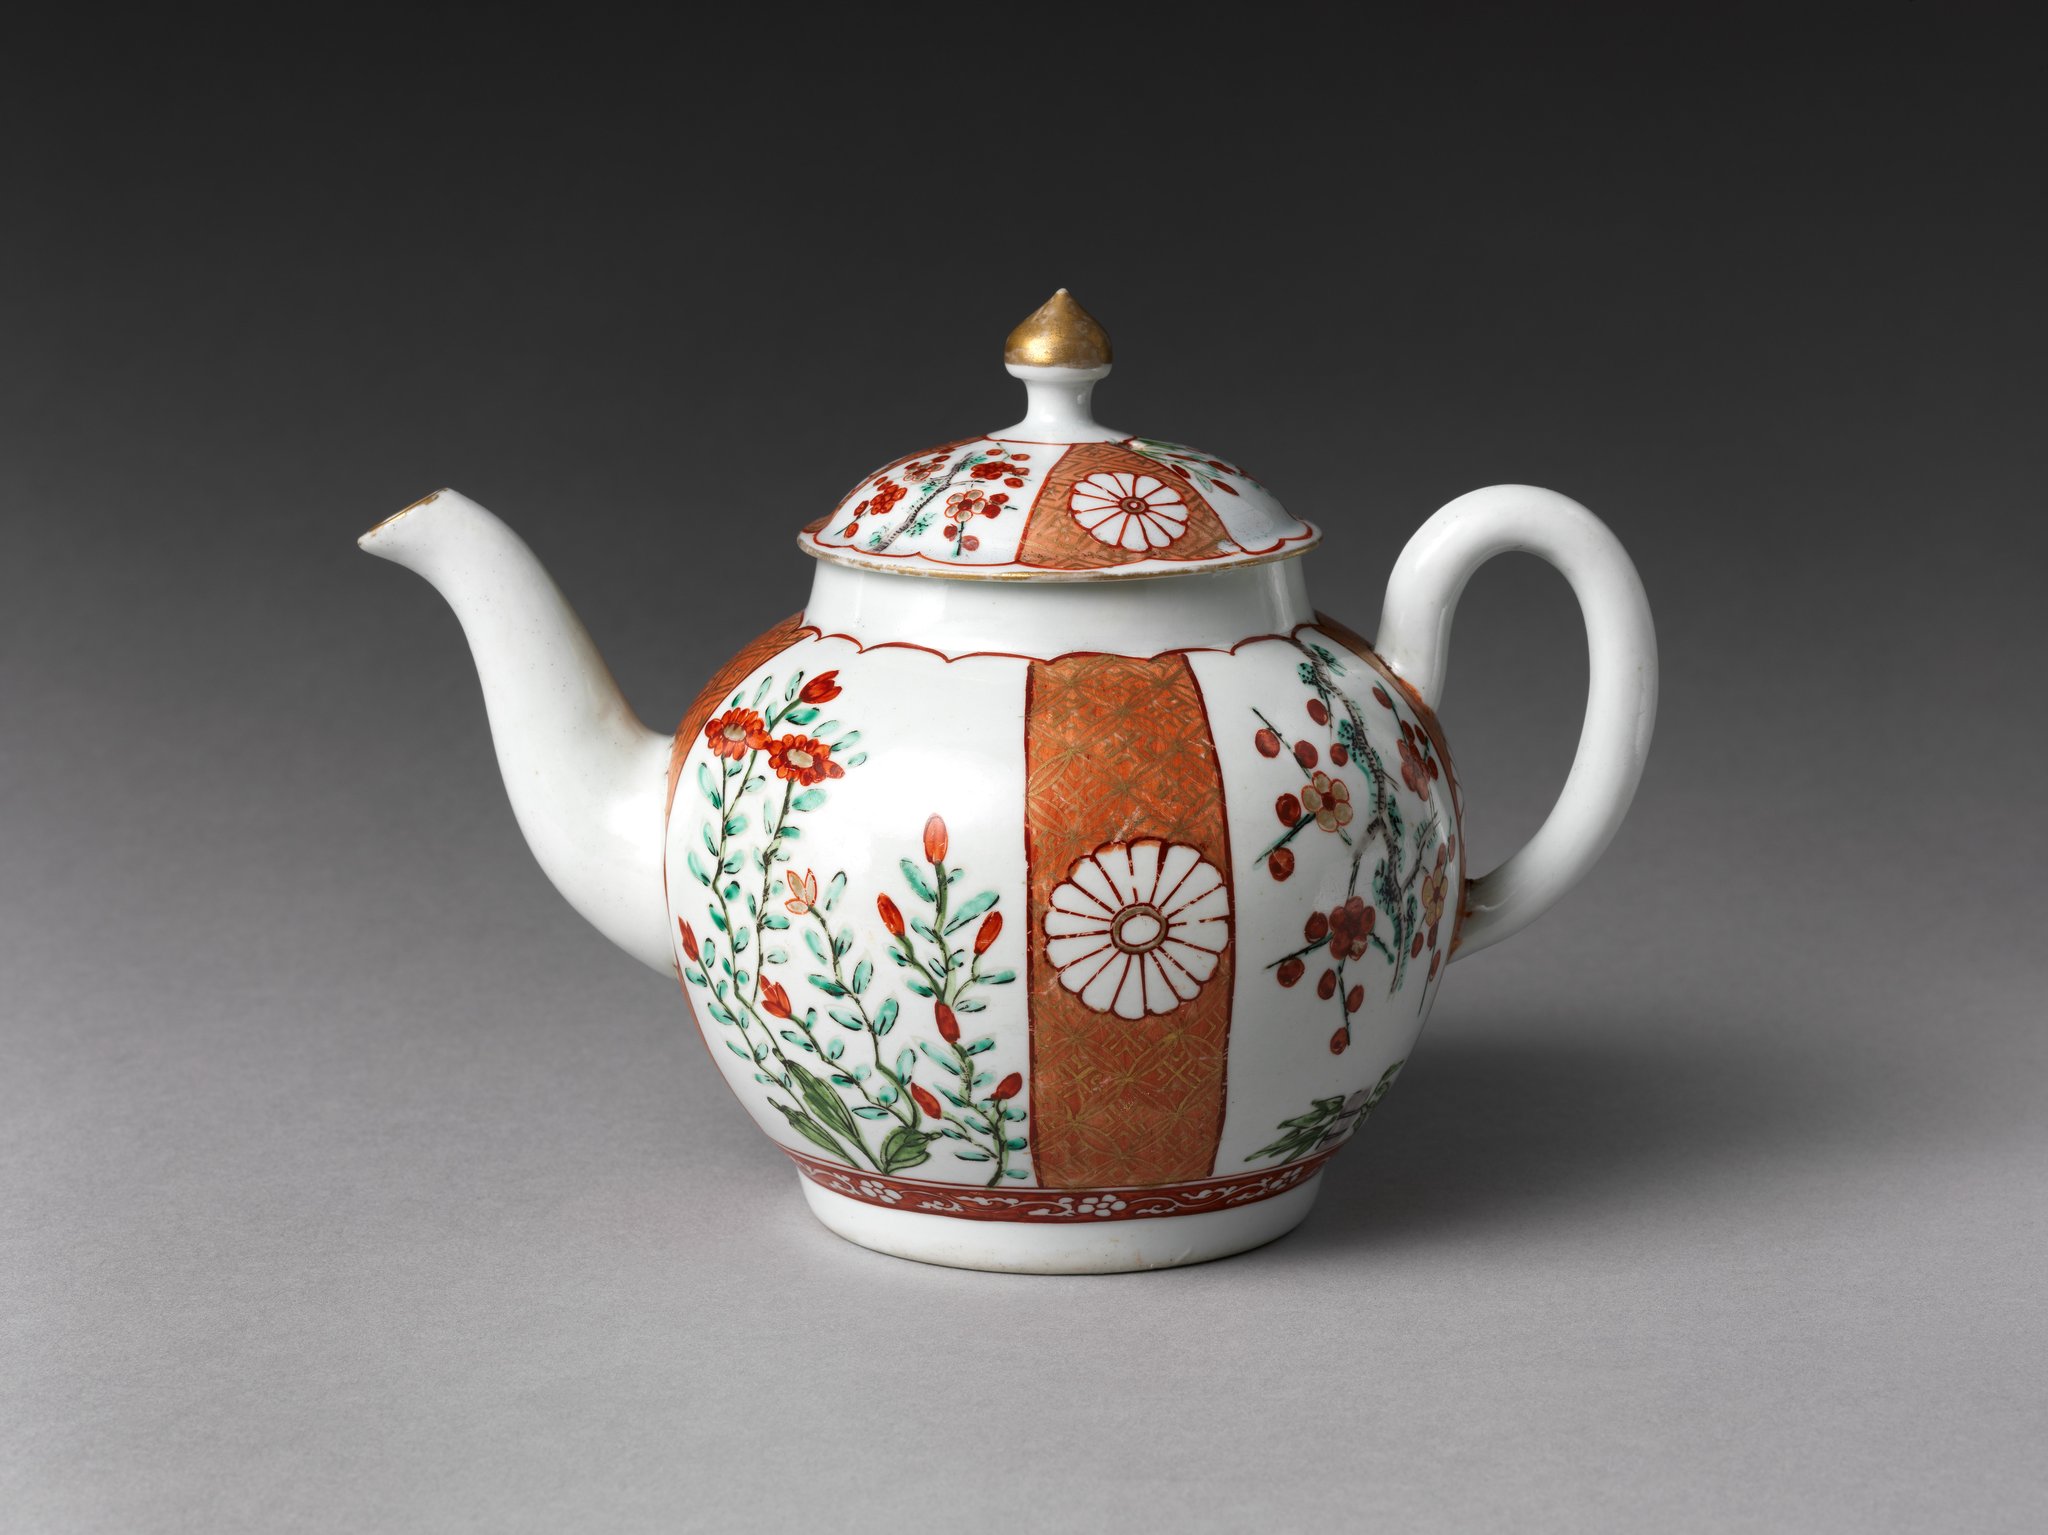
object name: teapot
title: Teapot with Japanese-style flowers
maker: worcester factory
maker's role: factory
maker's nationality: british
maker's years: 1751-2008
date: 1770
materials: enamel, glaze, soft paste porcelain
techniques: painting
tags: flowers